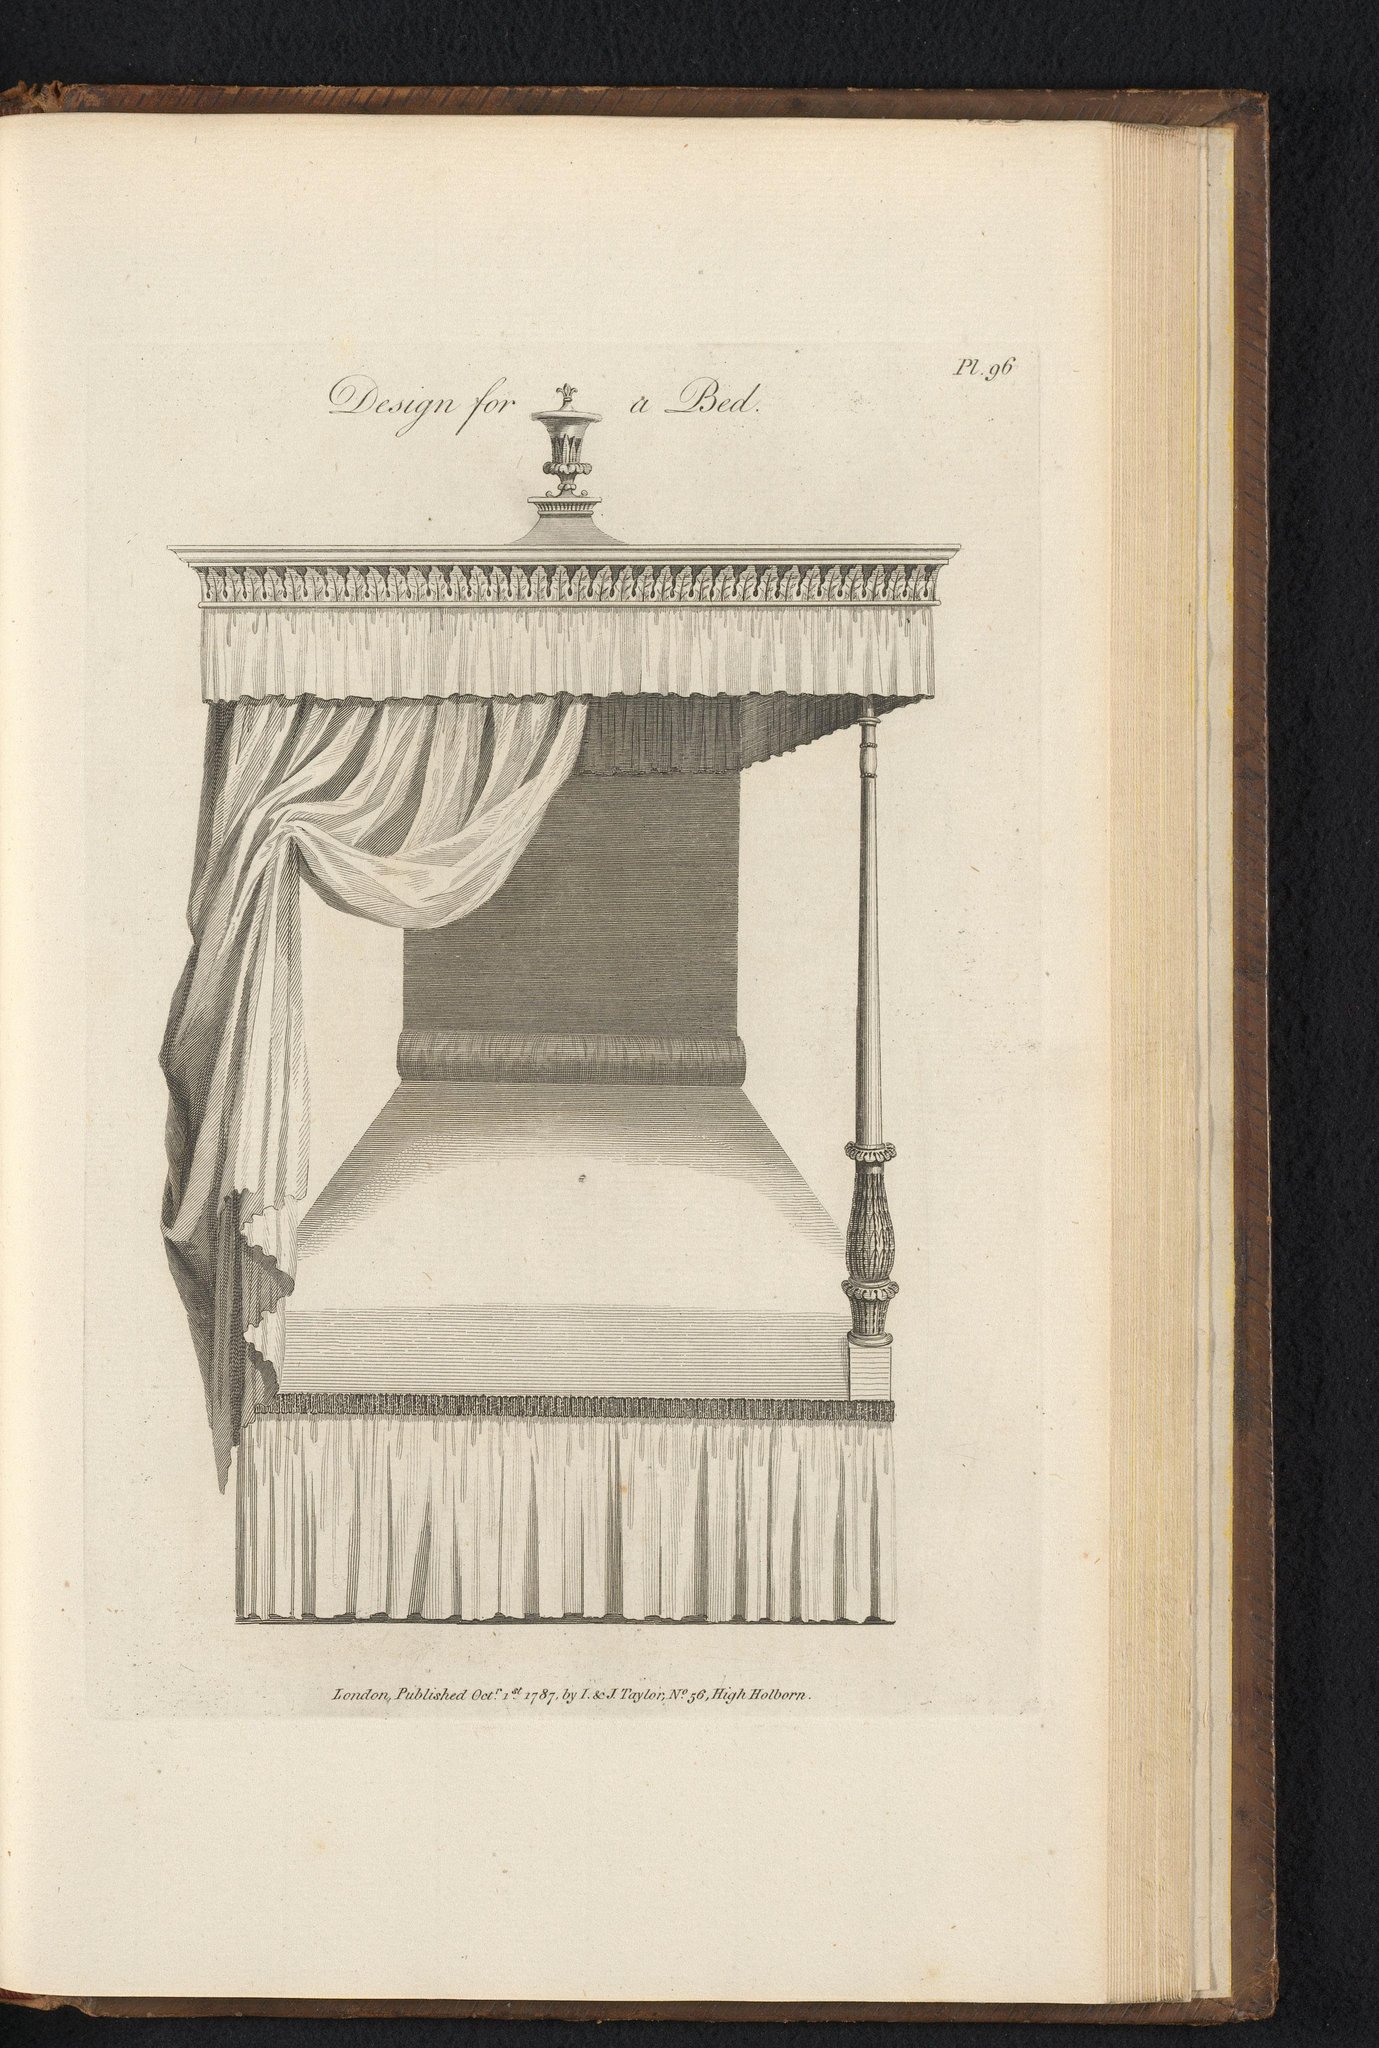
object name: page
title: Design for a Bed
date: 1787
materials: paper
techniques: engraving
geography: holborn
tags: bed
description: Genummerd: Pl. 96. Prent maakt deel uit van een boek.